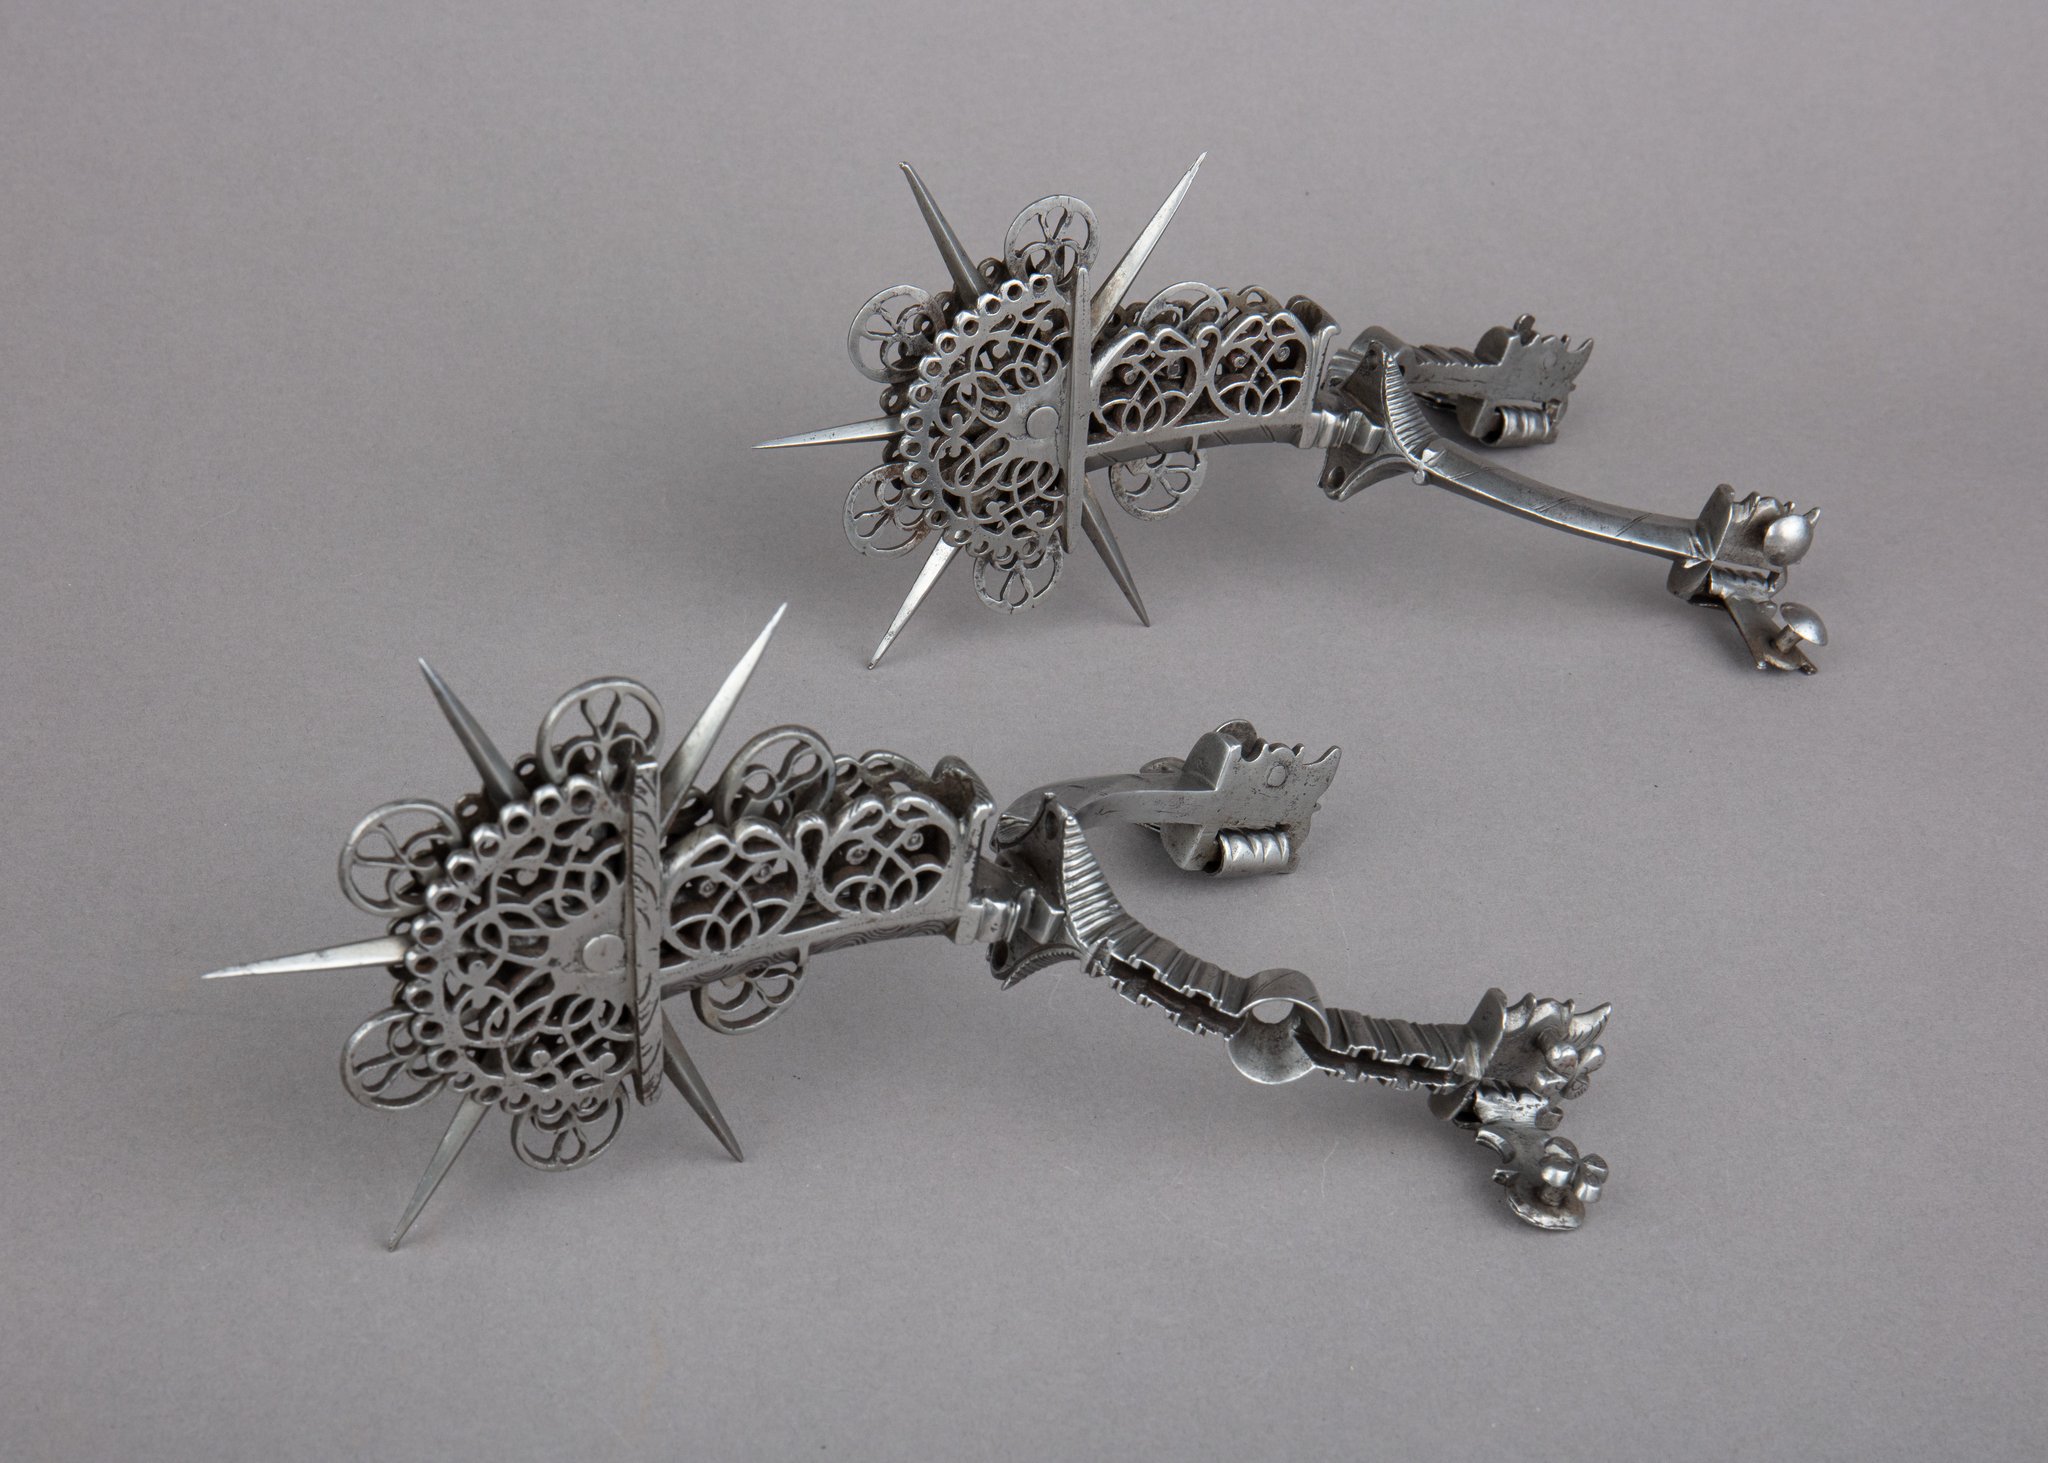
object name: spur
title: Pair of Rowel Spurs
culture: mexican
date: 1701-1800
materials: metal alloy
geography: mexico